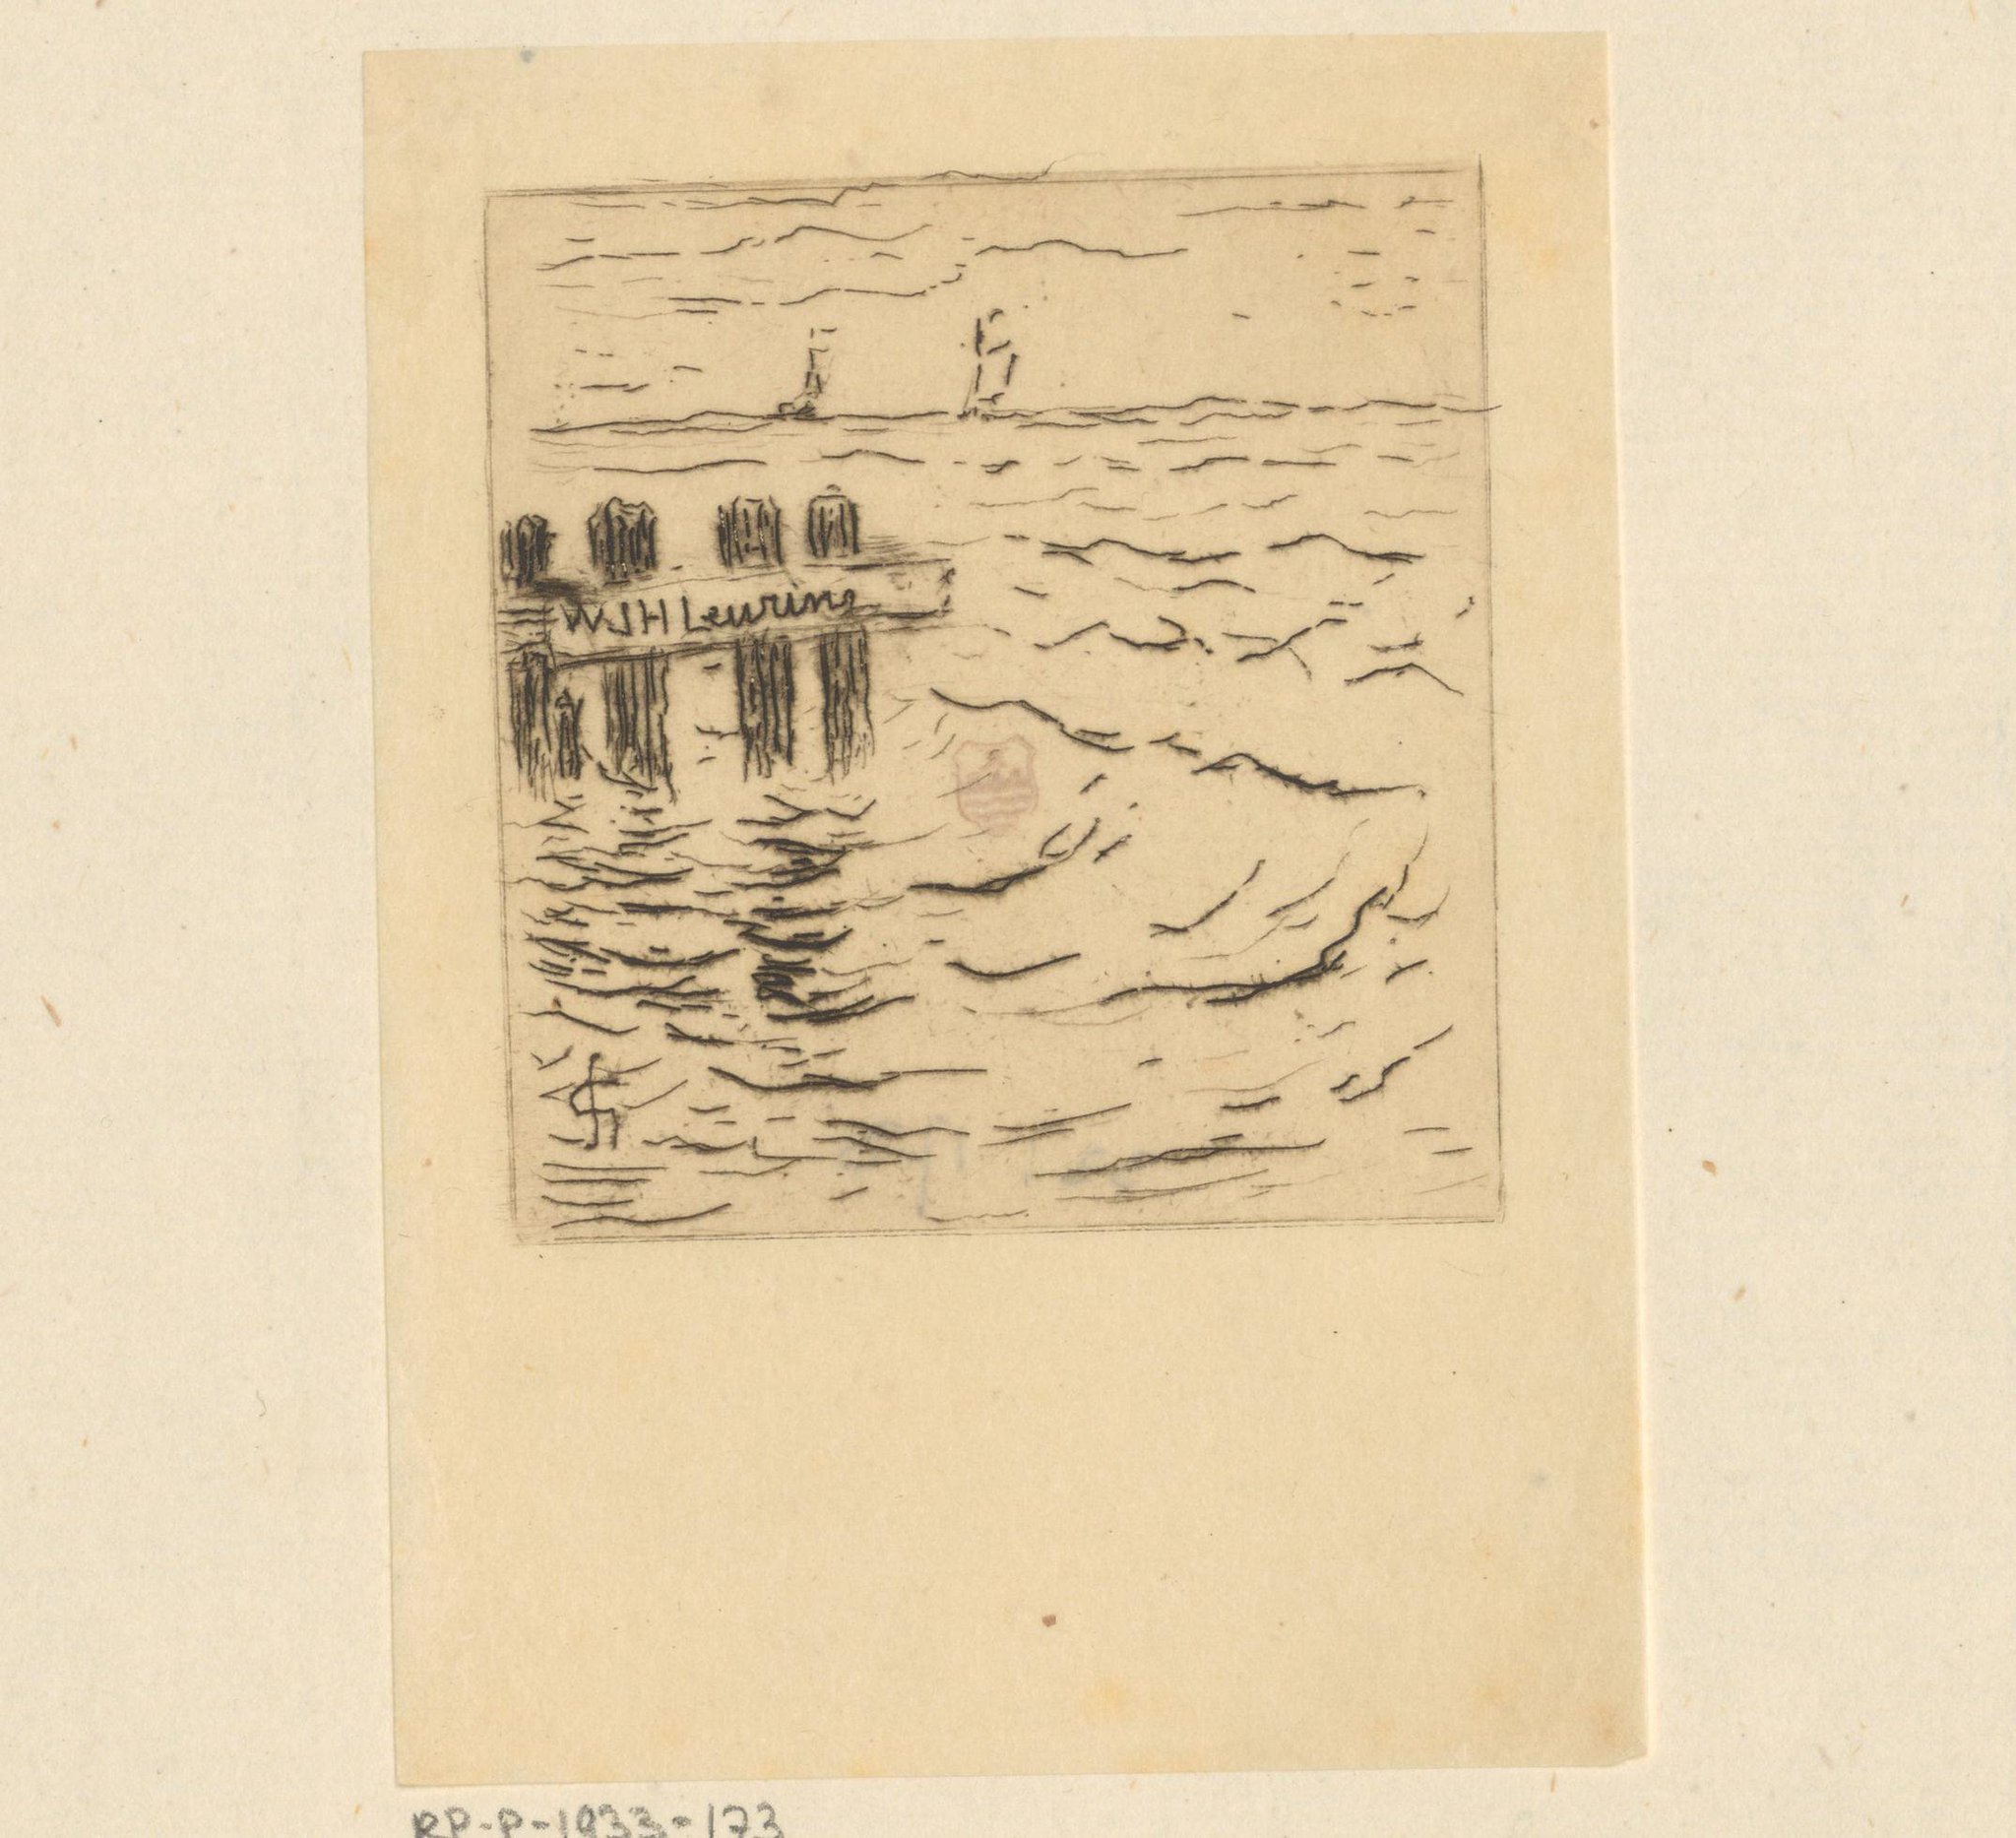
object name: bookplate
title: Ex libris van W.J.H. Leuring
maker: carel nicolaas storm van s-gravesande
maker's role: draughtsman, print maker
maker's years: 1841-1924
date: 1851-1924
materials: paper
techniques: drypoint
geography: netherlands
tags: willem leuring, surf, breakers, coast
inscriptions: collector's mark: Lugt 2760